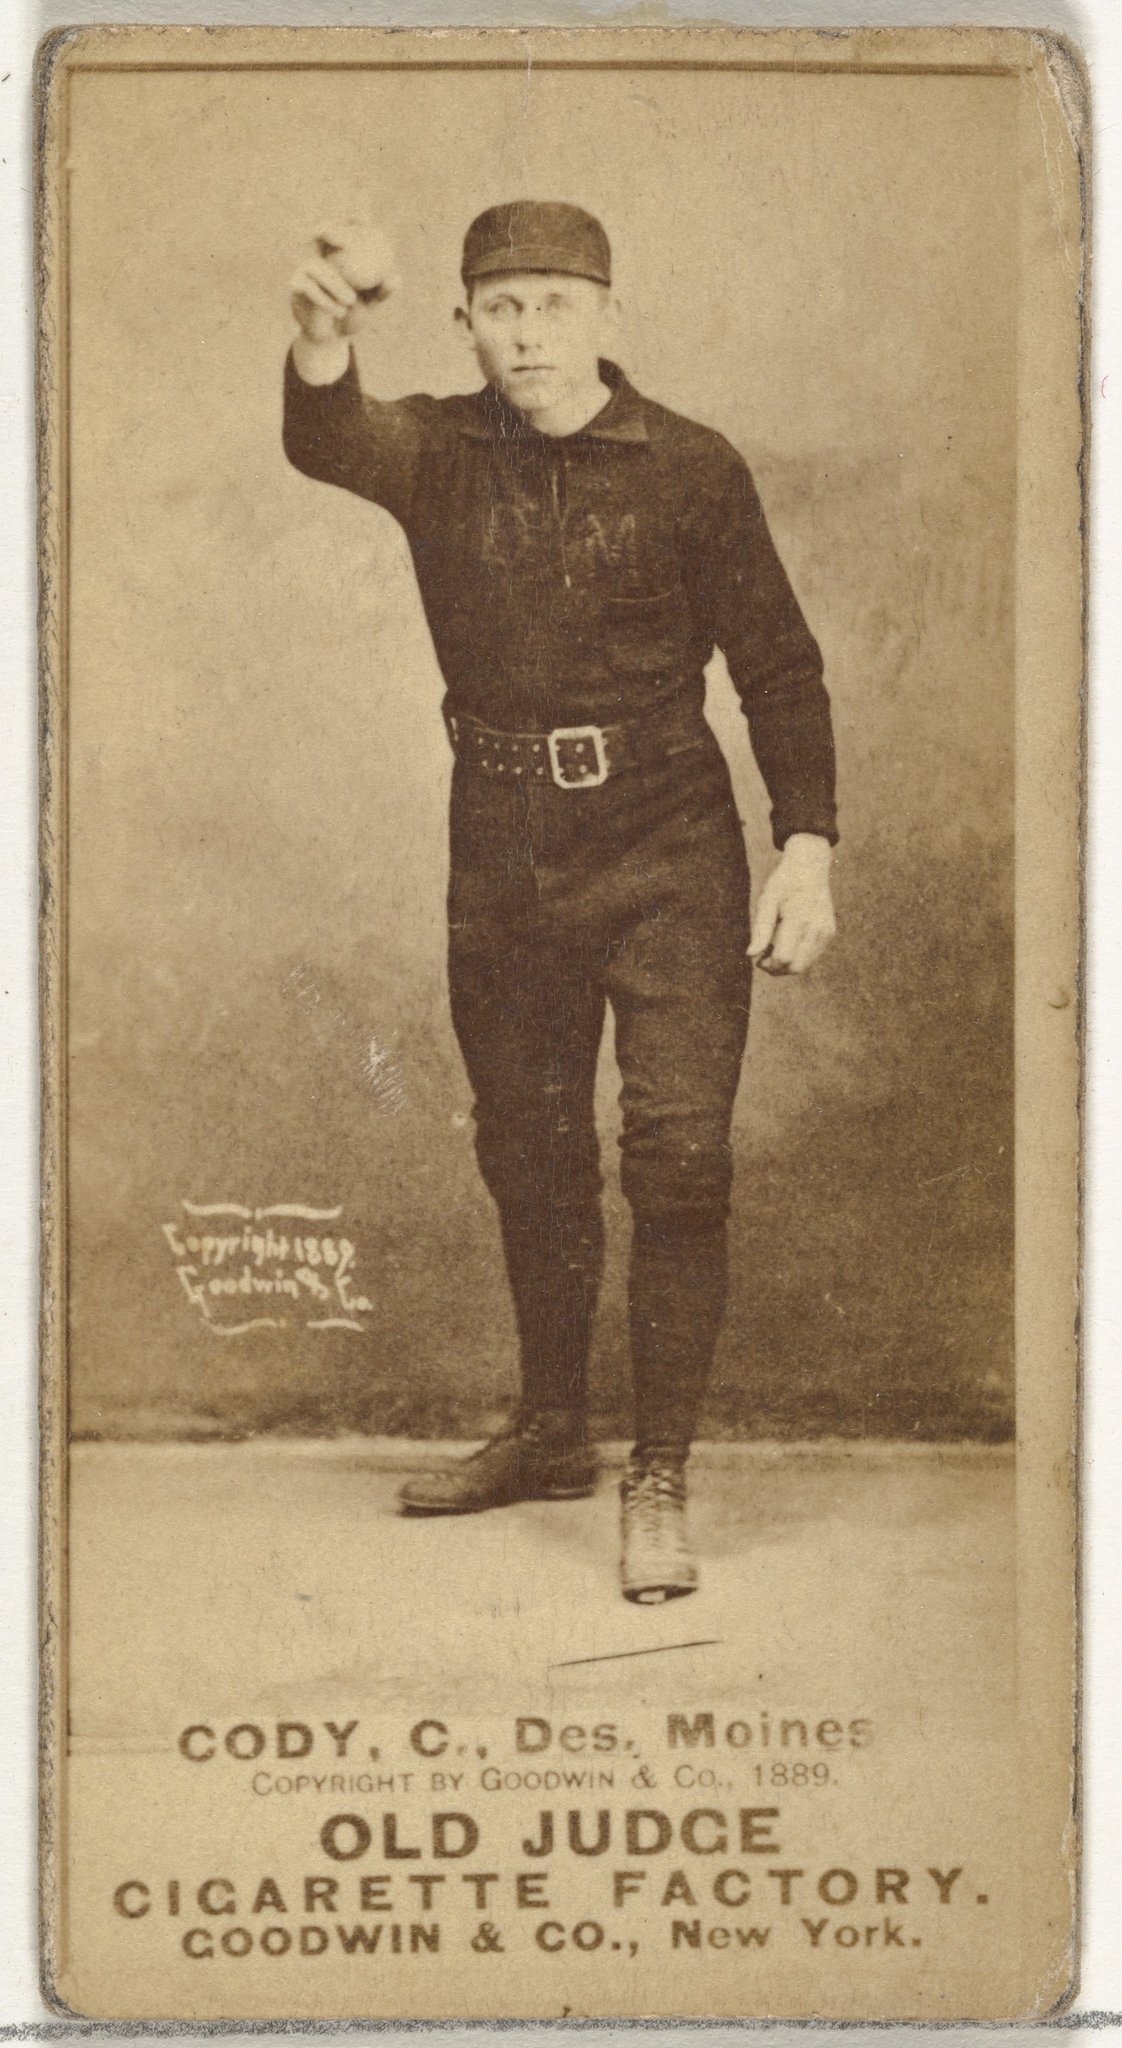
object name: baseball card, photograph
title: Michael J. Cody, Catcher, Des Moines Prohibitionists, from the Old Judge series (N172) for Old Judge Cigarettes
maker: goodwin & company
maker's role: publisher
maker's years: 1850-1950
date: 1889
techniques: albumen silver print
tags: men,portraits,baseball,athletes